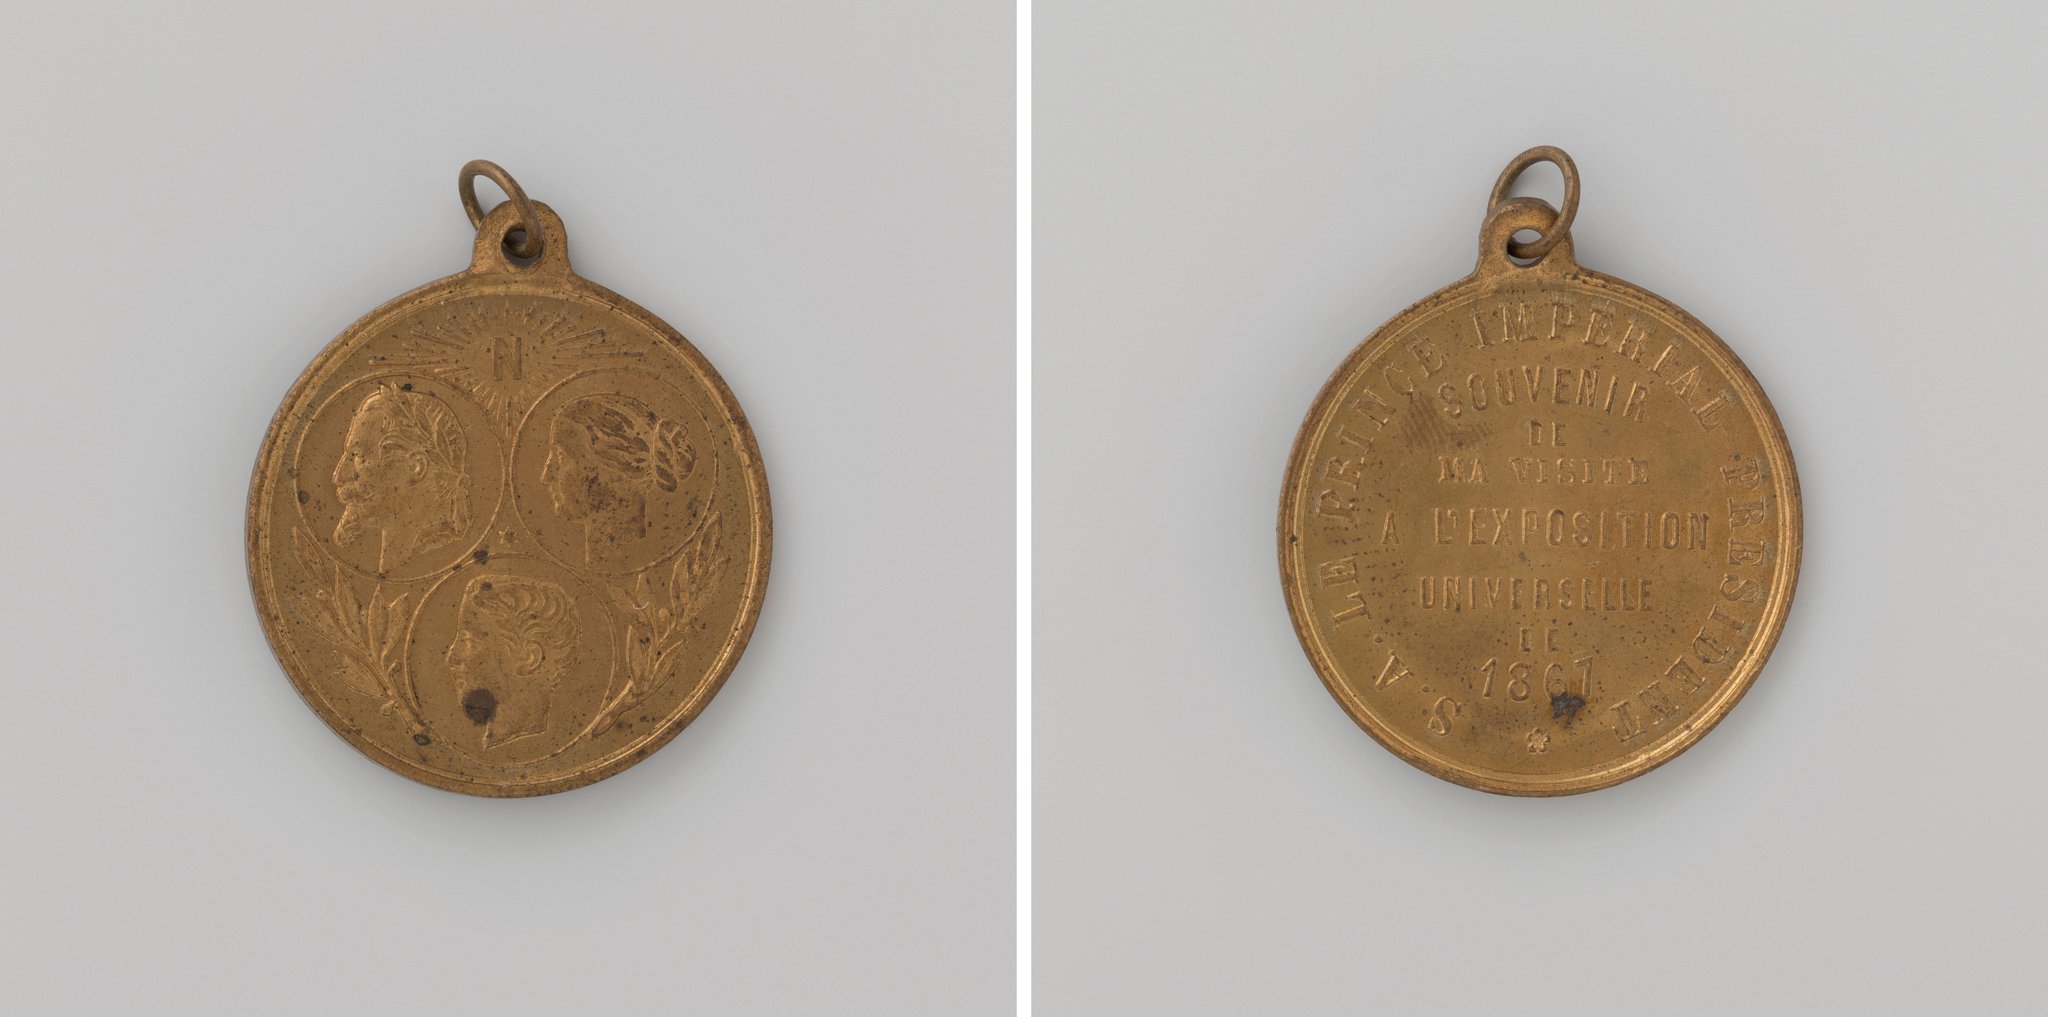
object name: history medal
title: Bezoek van de keizerlijke familie aan de wereldtentoonstelling te Parijs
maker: Anonymous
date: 1867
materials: metal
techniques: gilding, striking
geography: paris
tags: sevilla, london, napoleon iii (keizer der fransen), paris